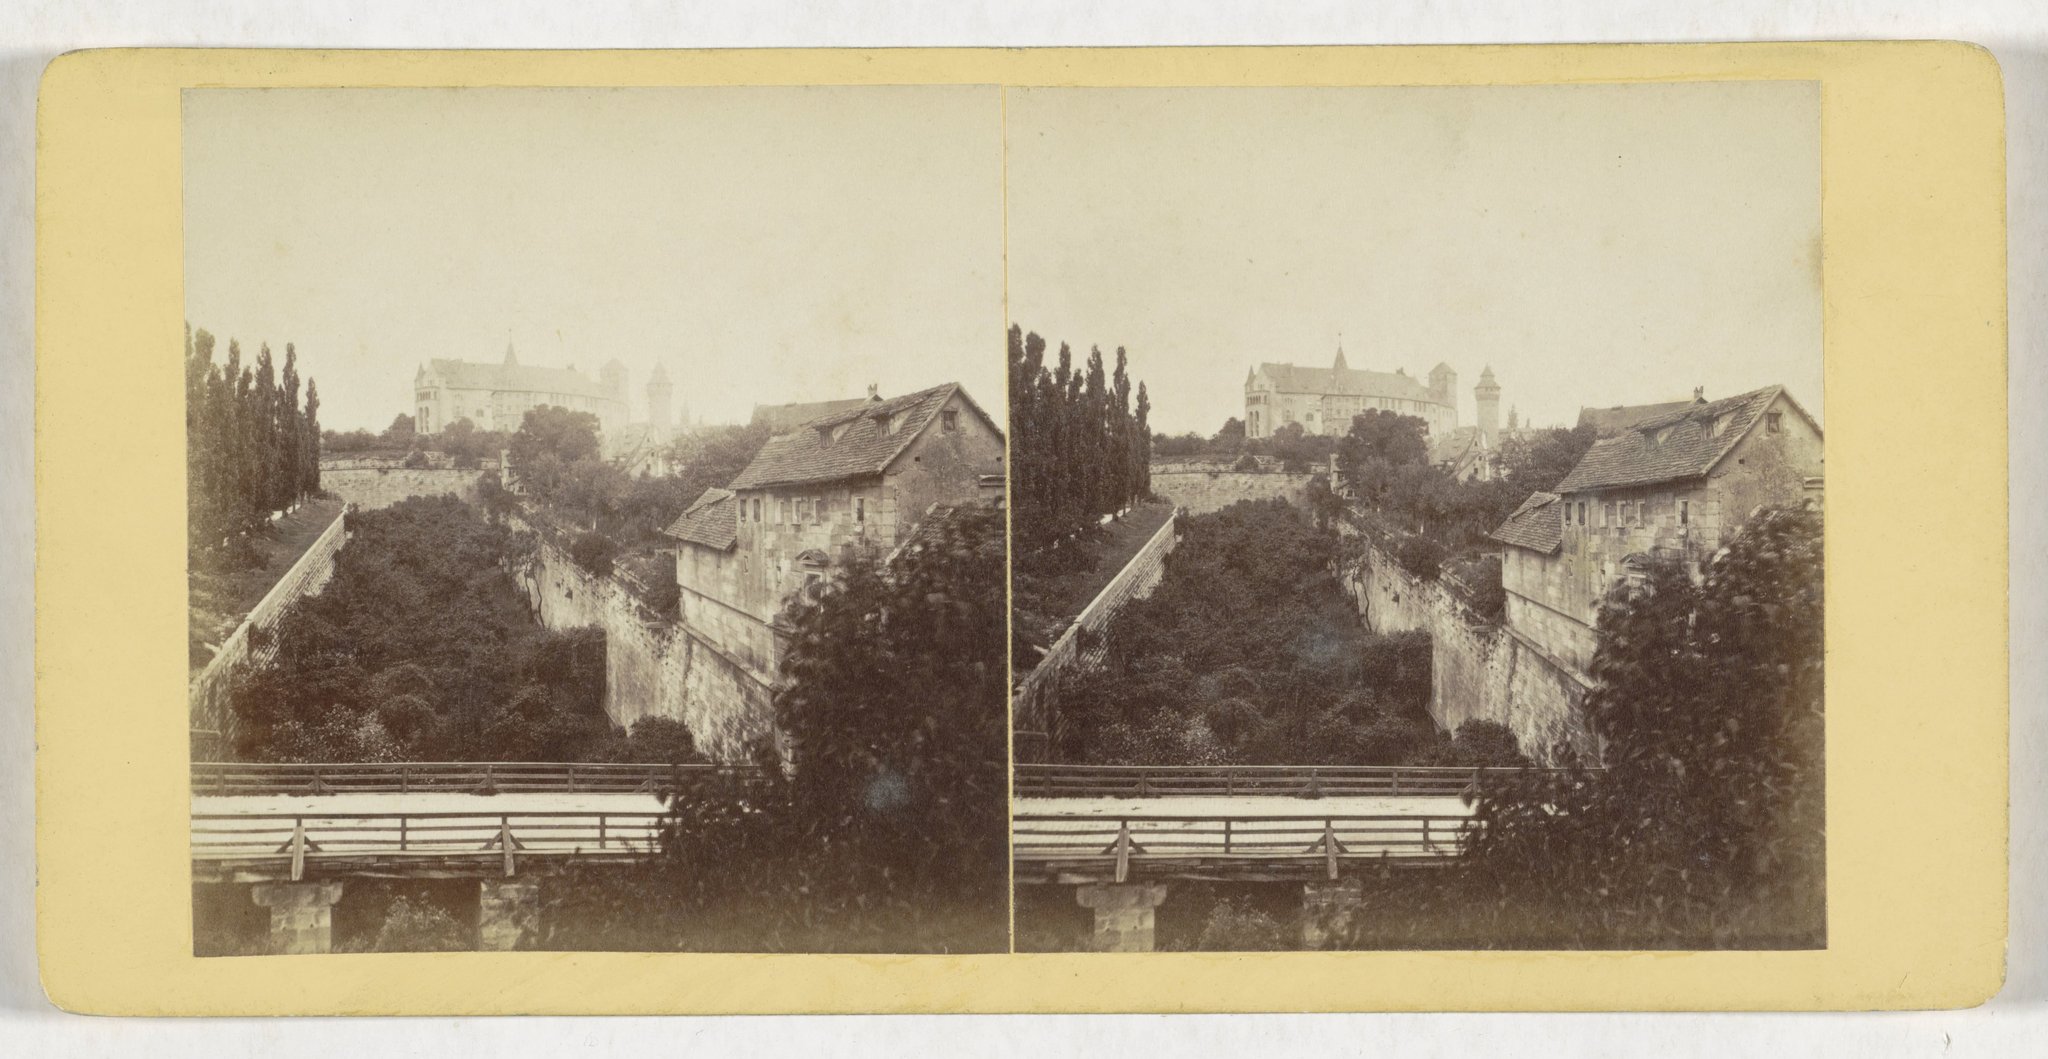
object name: stereograph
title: Nürnberg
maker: johann friedrich stiehm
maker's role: fotograaf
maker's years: 1826-1902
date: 1868-1888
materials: cardboard, paper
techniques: albumen print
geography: london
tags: moat ~ fortified city, castle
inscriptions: number: ‘No. 21.’